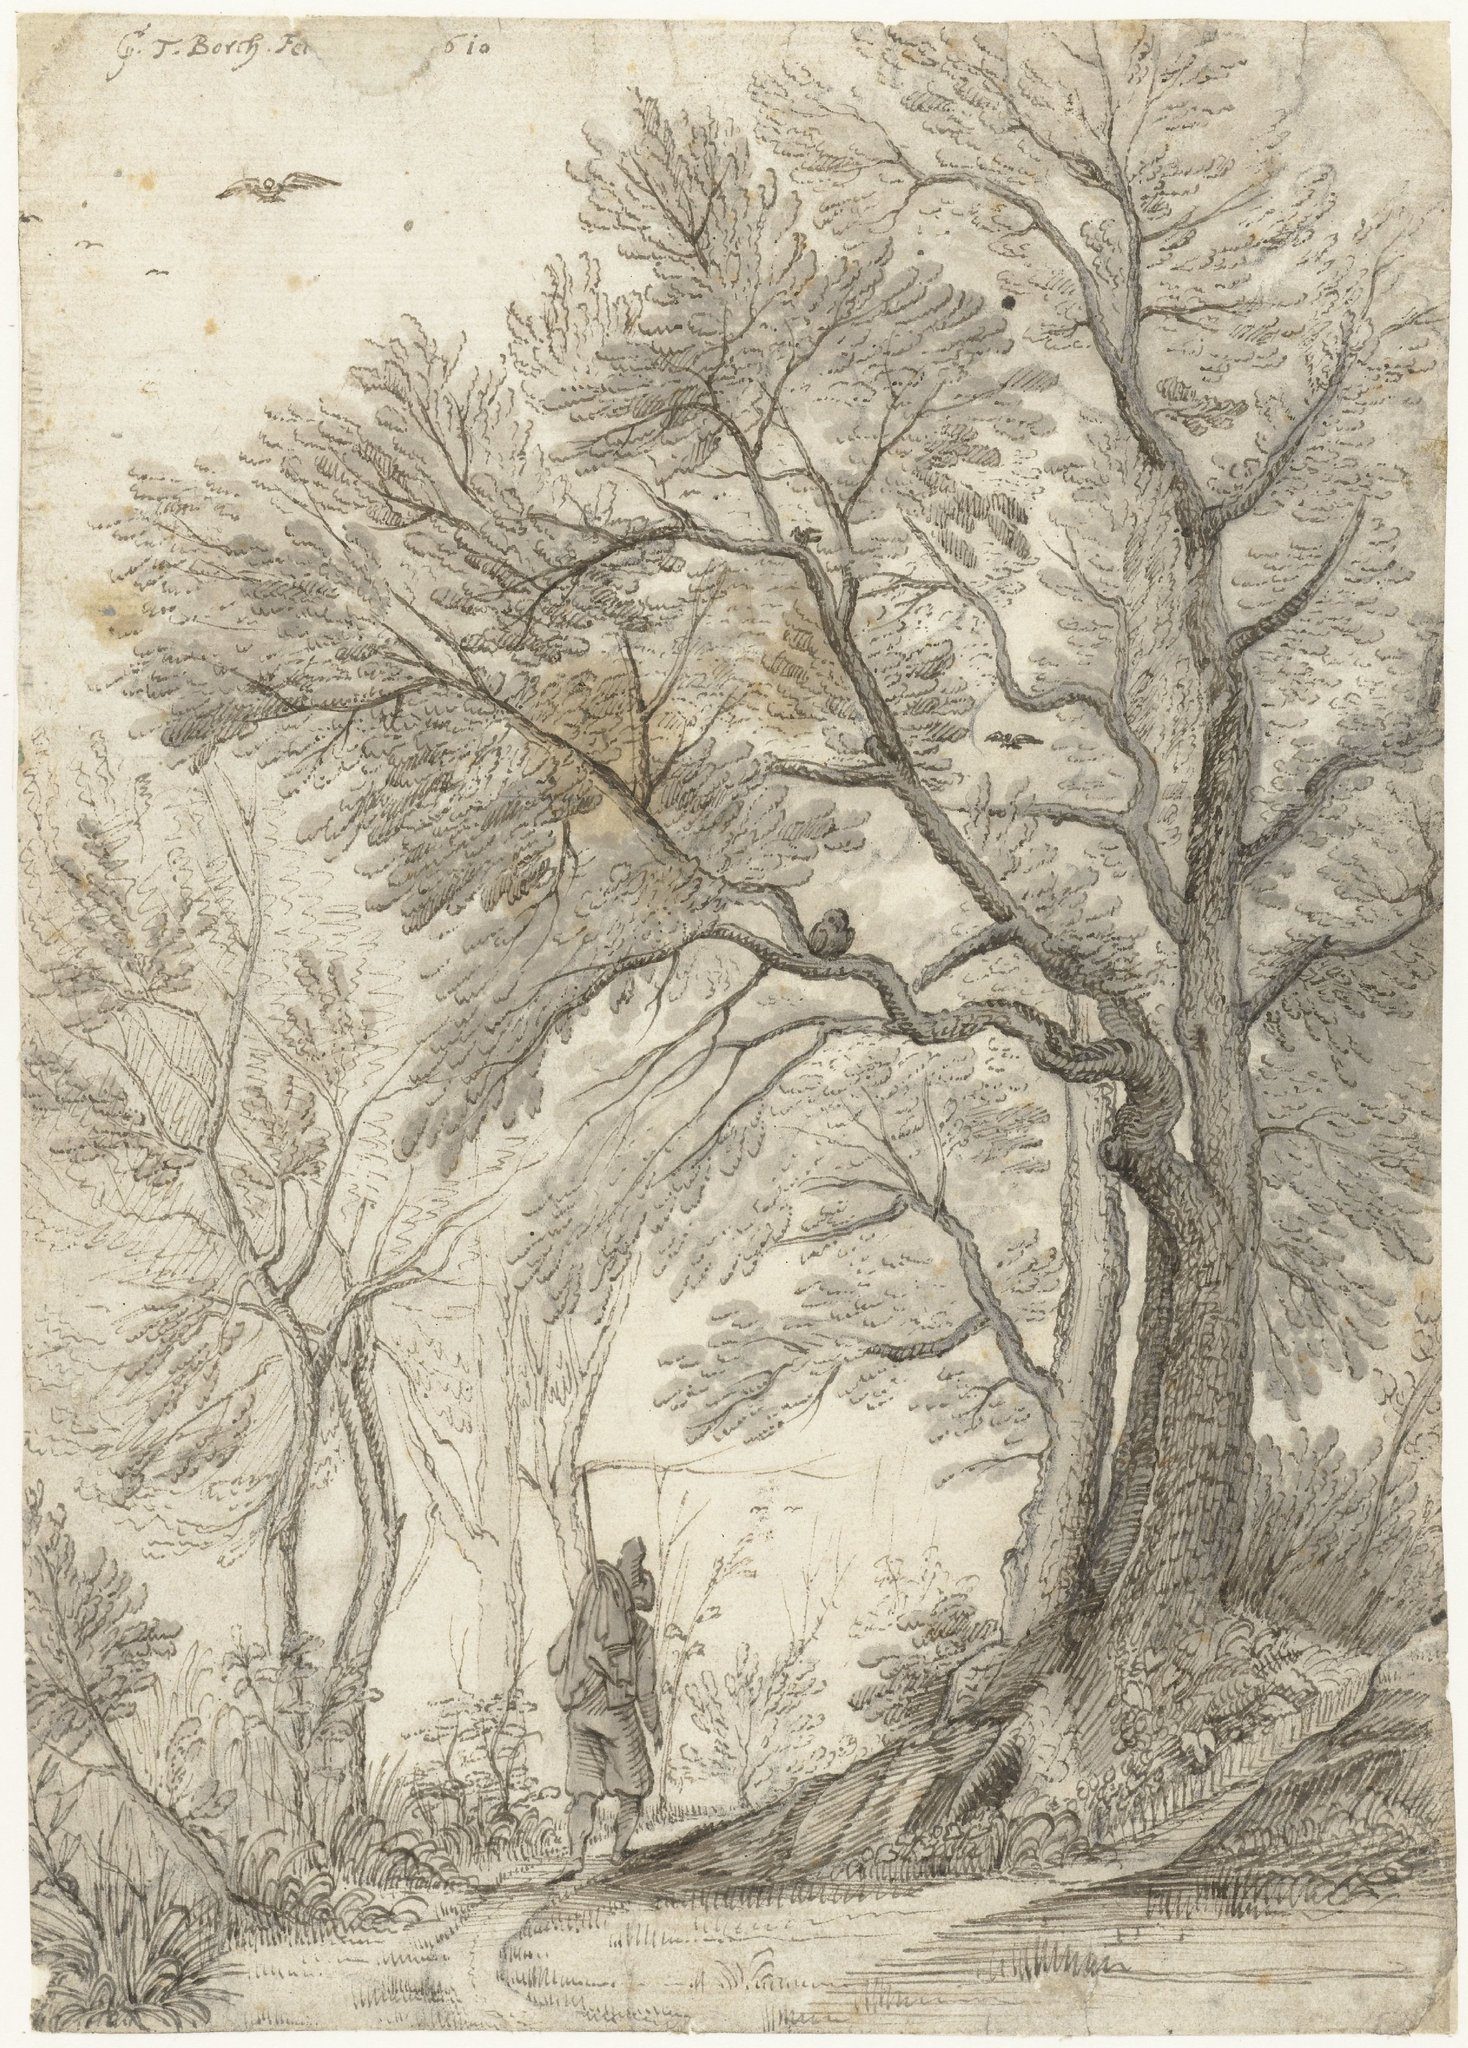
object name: drawing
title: Bos van de Villa Madama buiten Rome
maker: gerard ter borch (i)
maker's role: draughtsman, print maker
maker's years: 1584-1662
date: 1610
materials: chalk, ink, paper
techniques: brush, pen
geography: rome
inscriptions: annotation: ‘in vinia maddamma’, signature and date: ‘G.T.Borch. Fec.[ Anno 1] 610’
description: Tekening uit het Romeinse schetsboek van de kunstenaar.